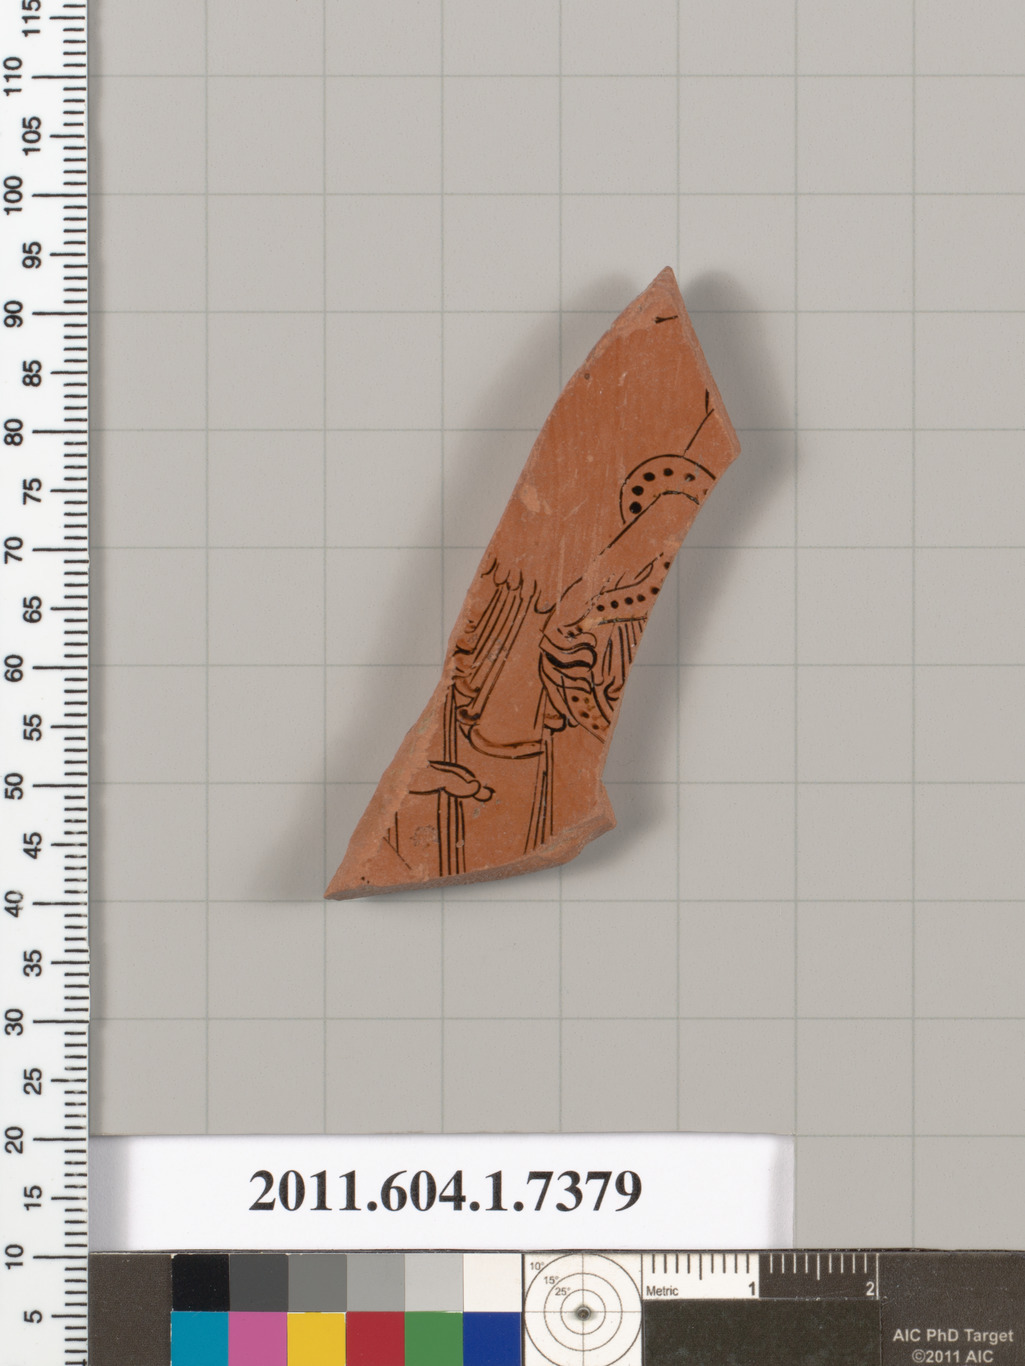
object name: kylix fragment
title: Terracotta fragment of a kylix (drinking cup)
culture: greek, attic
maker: makron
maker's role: artist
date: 500-480 BCE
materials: terracotta